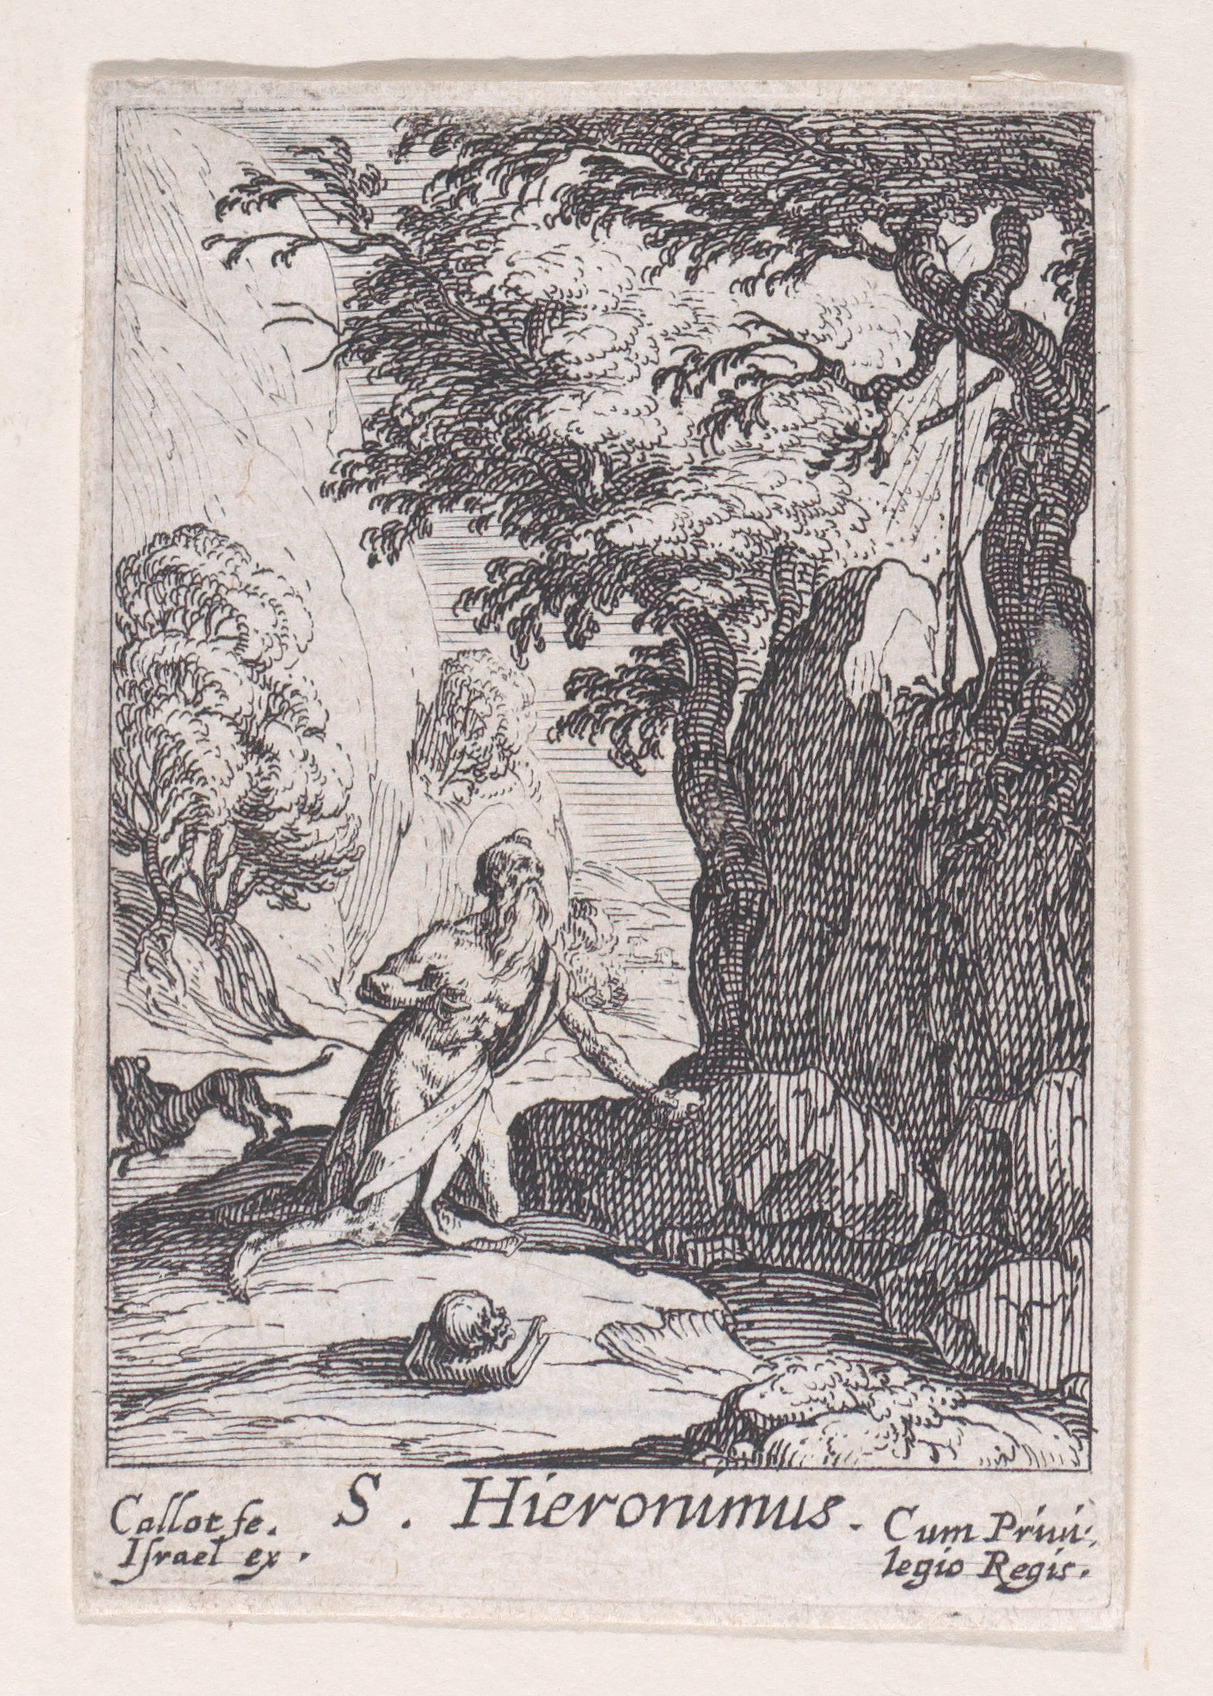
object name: print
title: St. Jerome, from "Les Pénitents et Pénitentes" (The Penitents)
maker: jacques callot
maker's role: artist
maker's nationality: french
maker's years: 1592-1635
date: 1632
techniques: etching